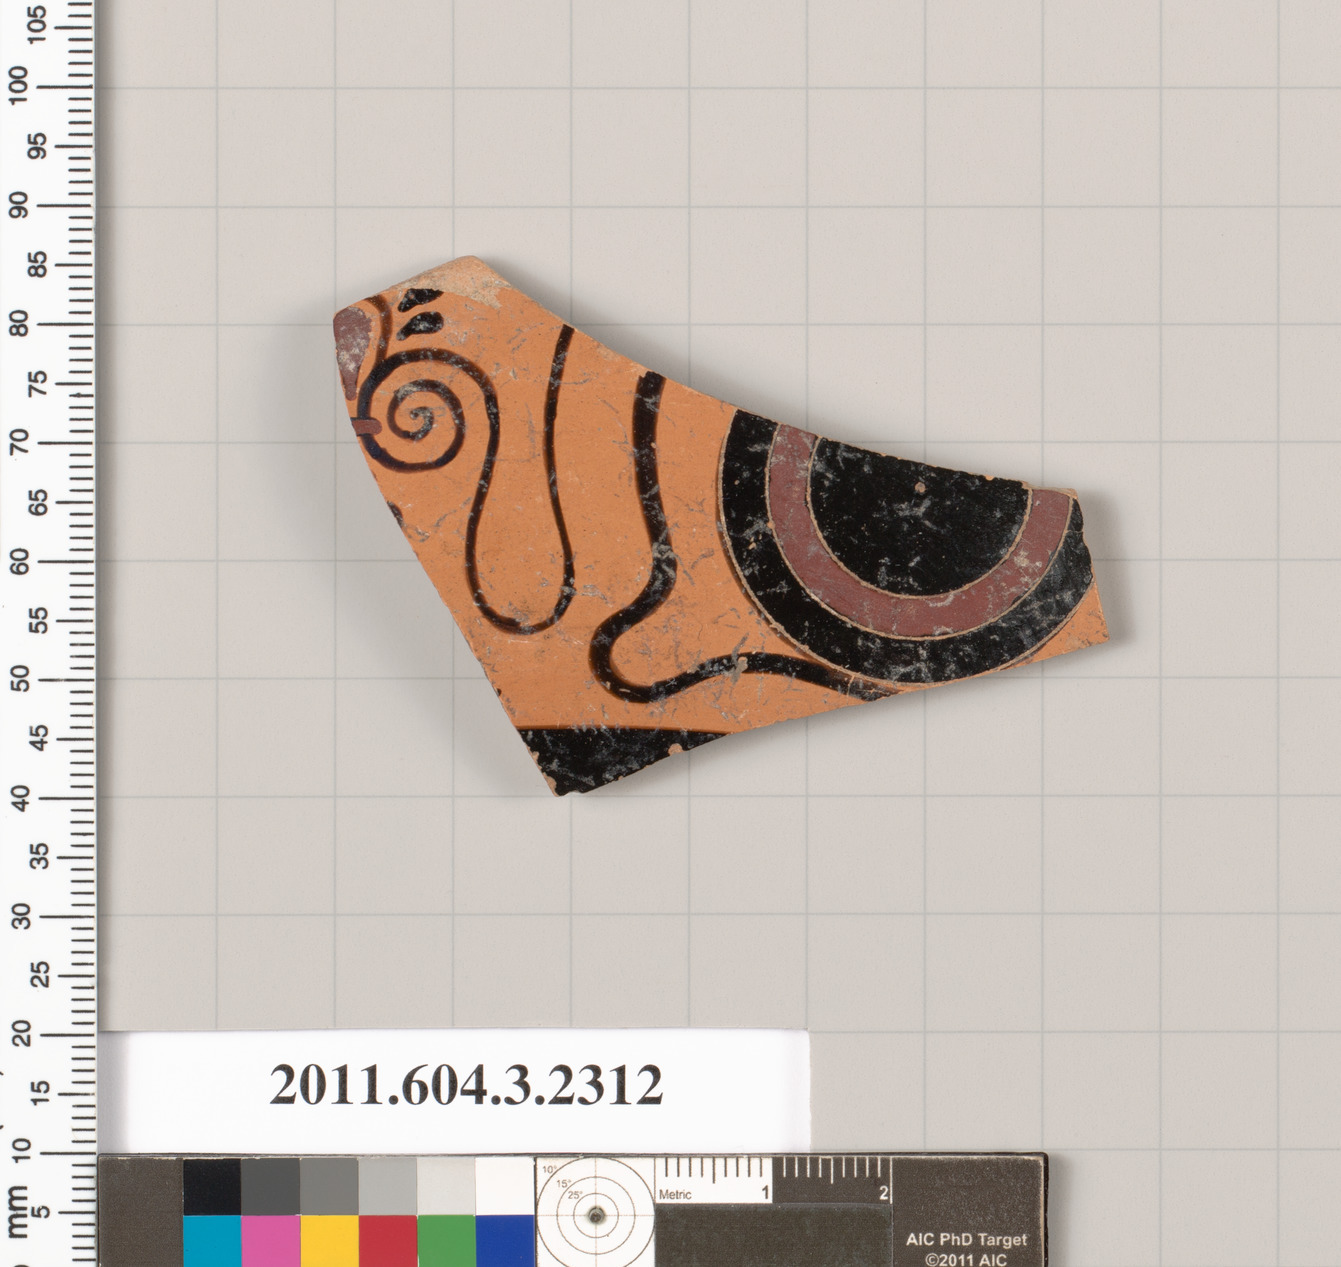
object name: kylix fragment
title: Terracotta fragment of a kylix: eye-cup (drinking cup)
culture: greek, attic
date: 540-530 BCE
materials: terracotta